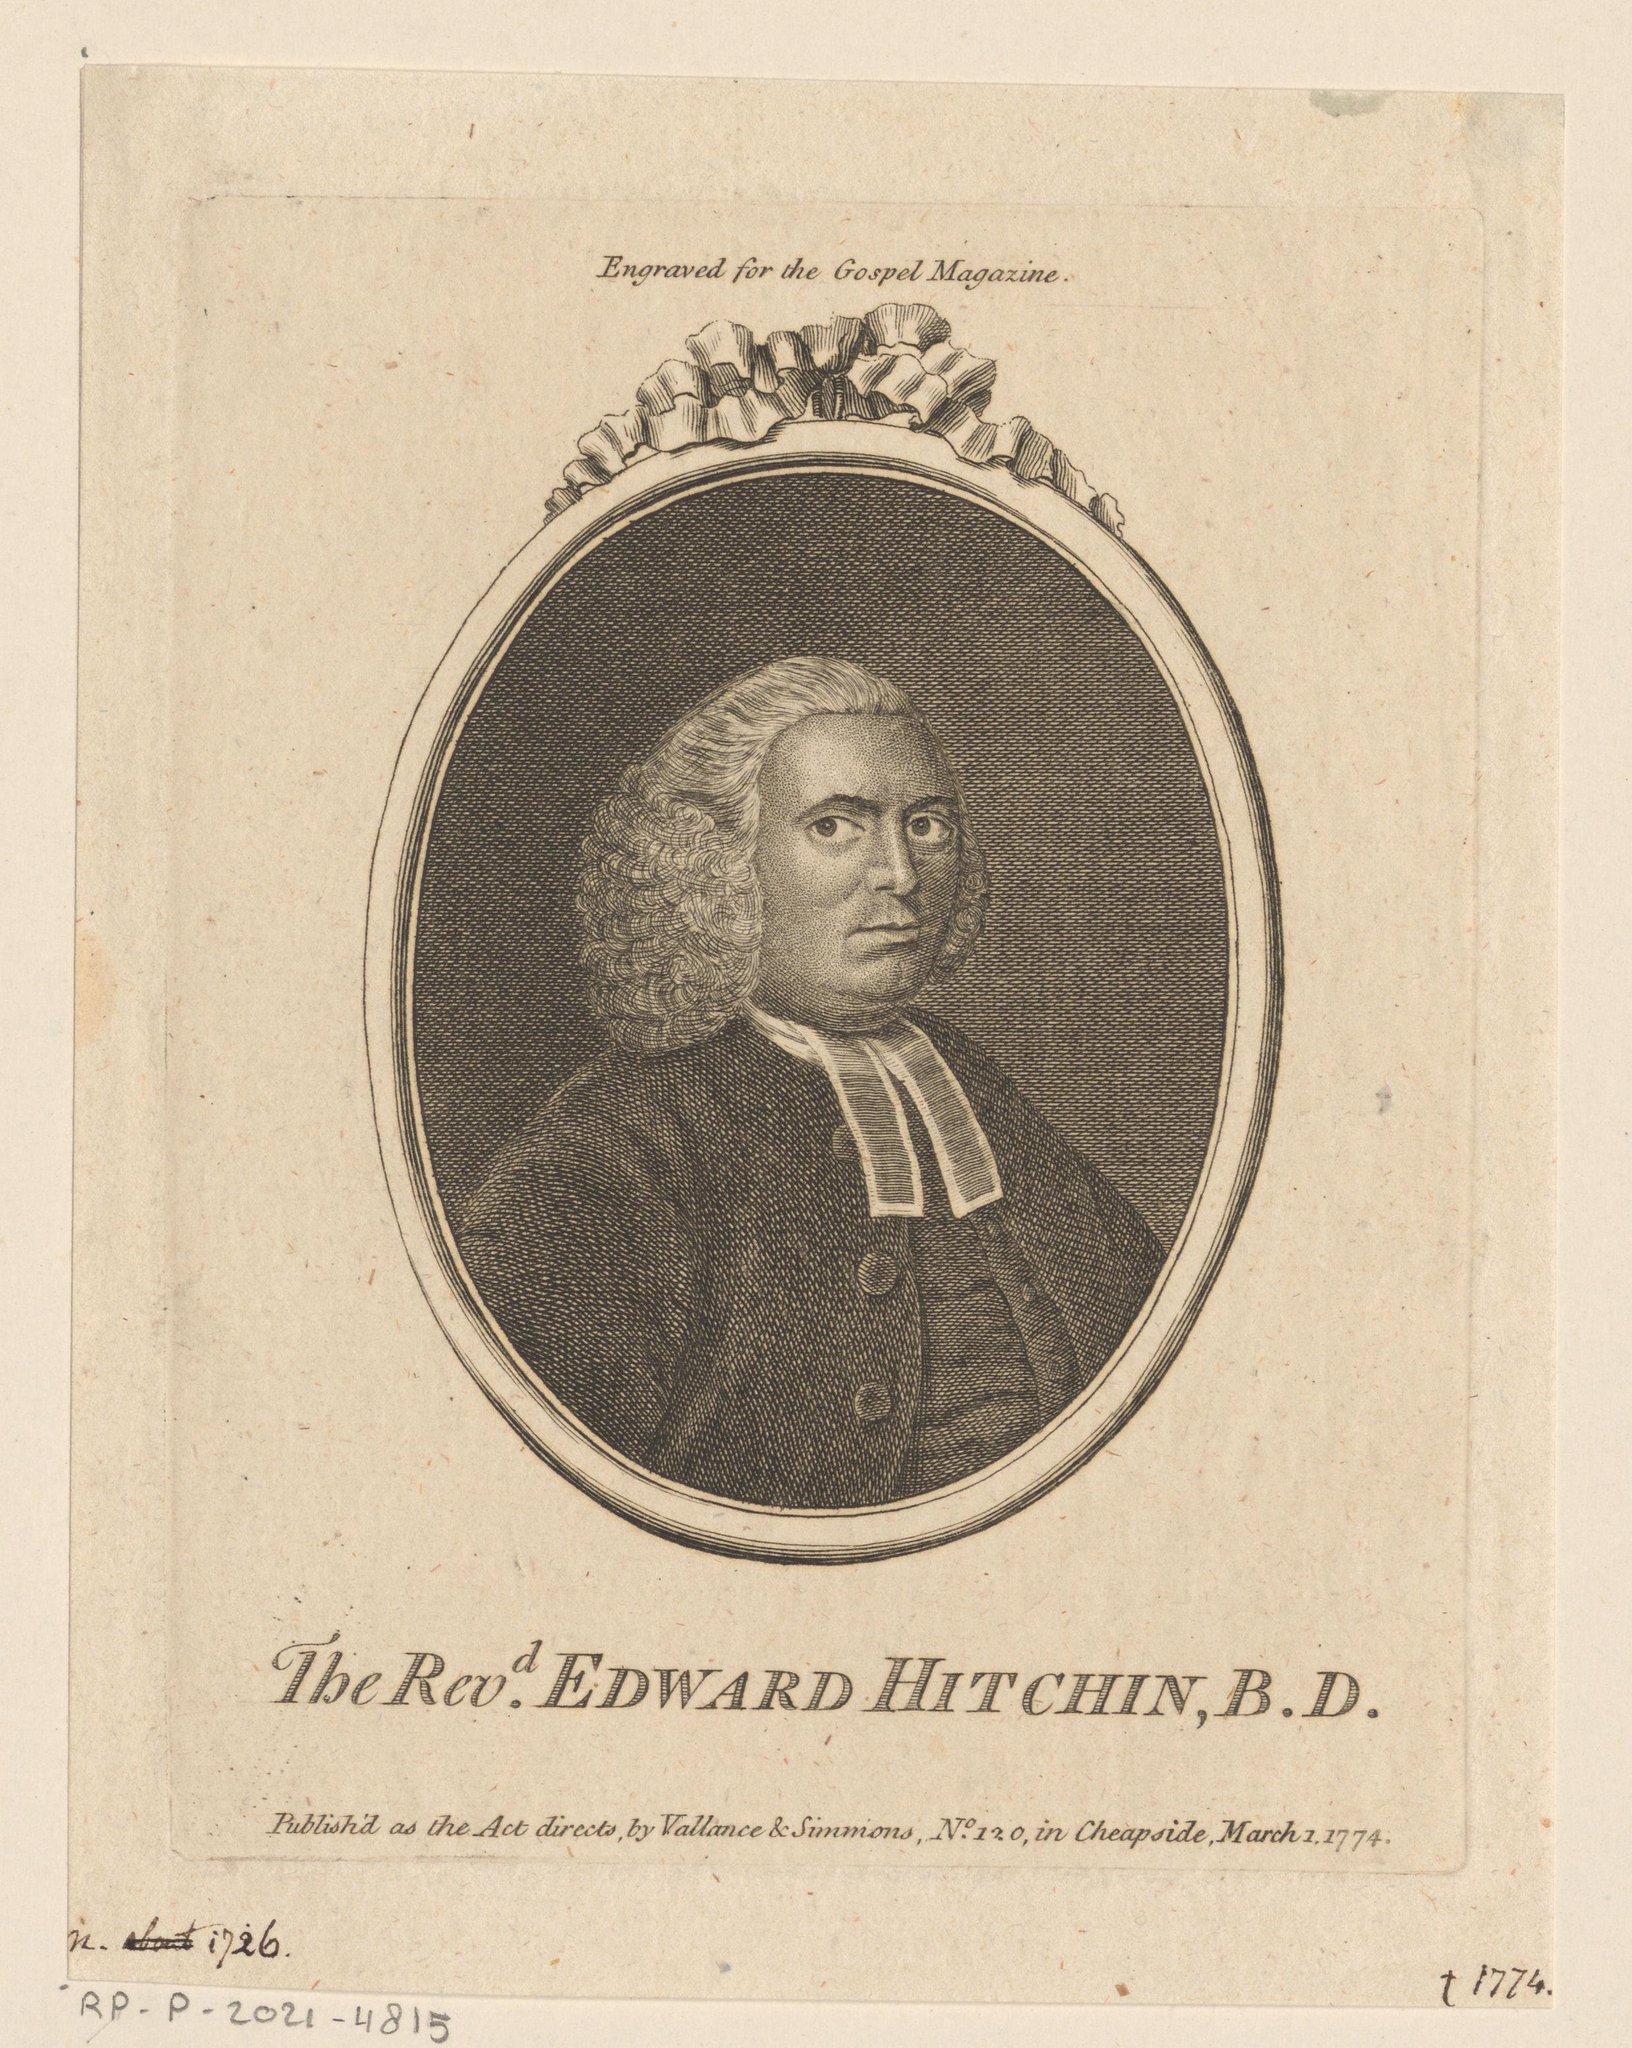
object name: print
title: Portret van Edward Hitchin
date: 1703-1774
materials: paper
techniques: engraving, etching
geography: london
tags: historical persons, portrait of a writer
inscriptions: date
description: Prent uit: The Gospel Magazine, februari 1774.